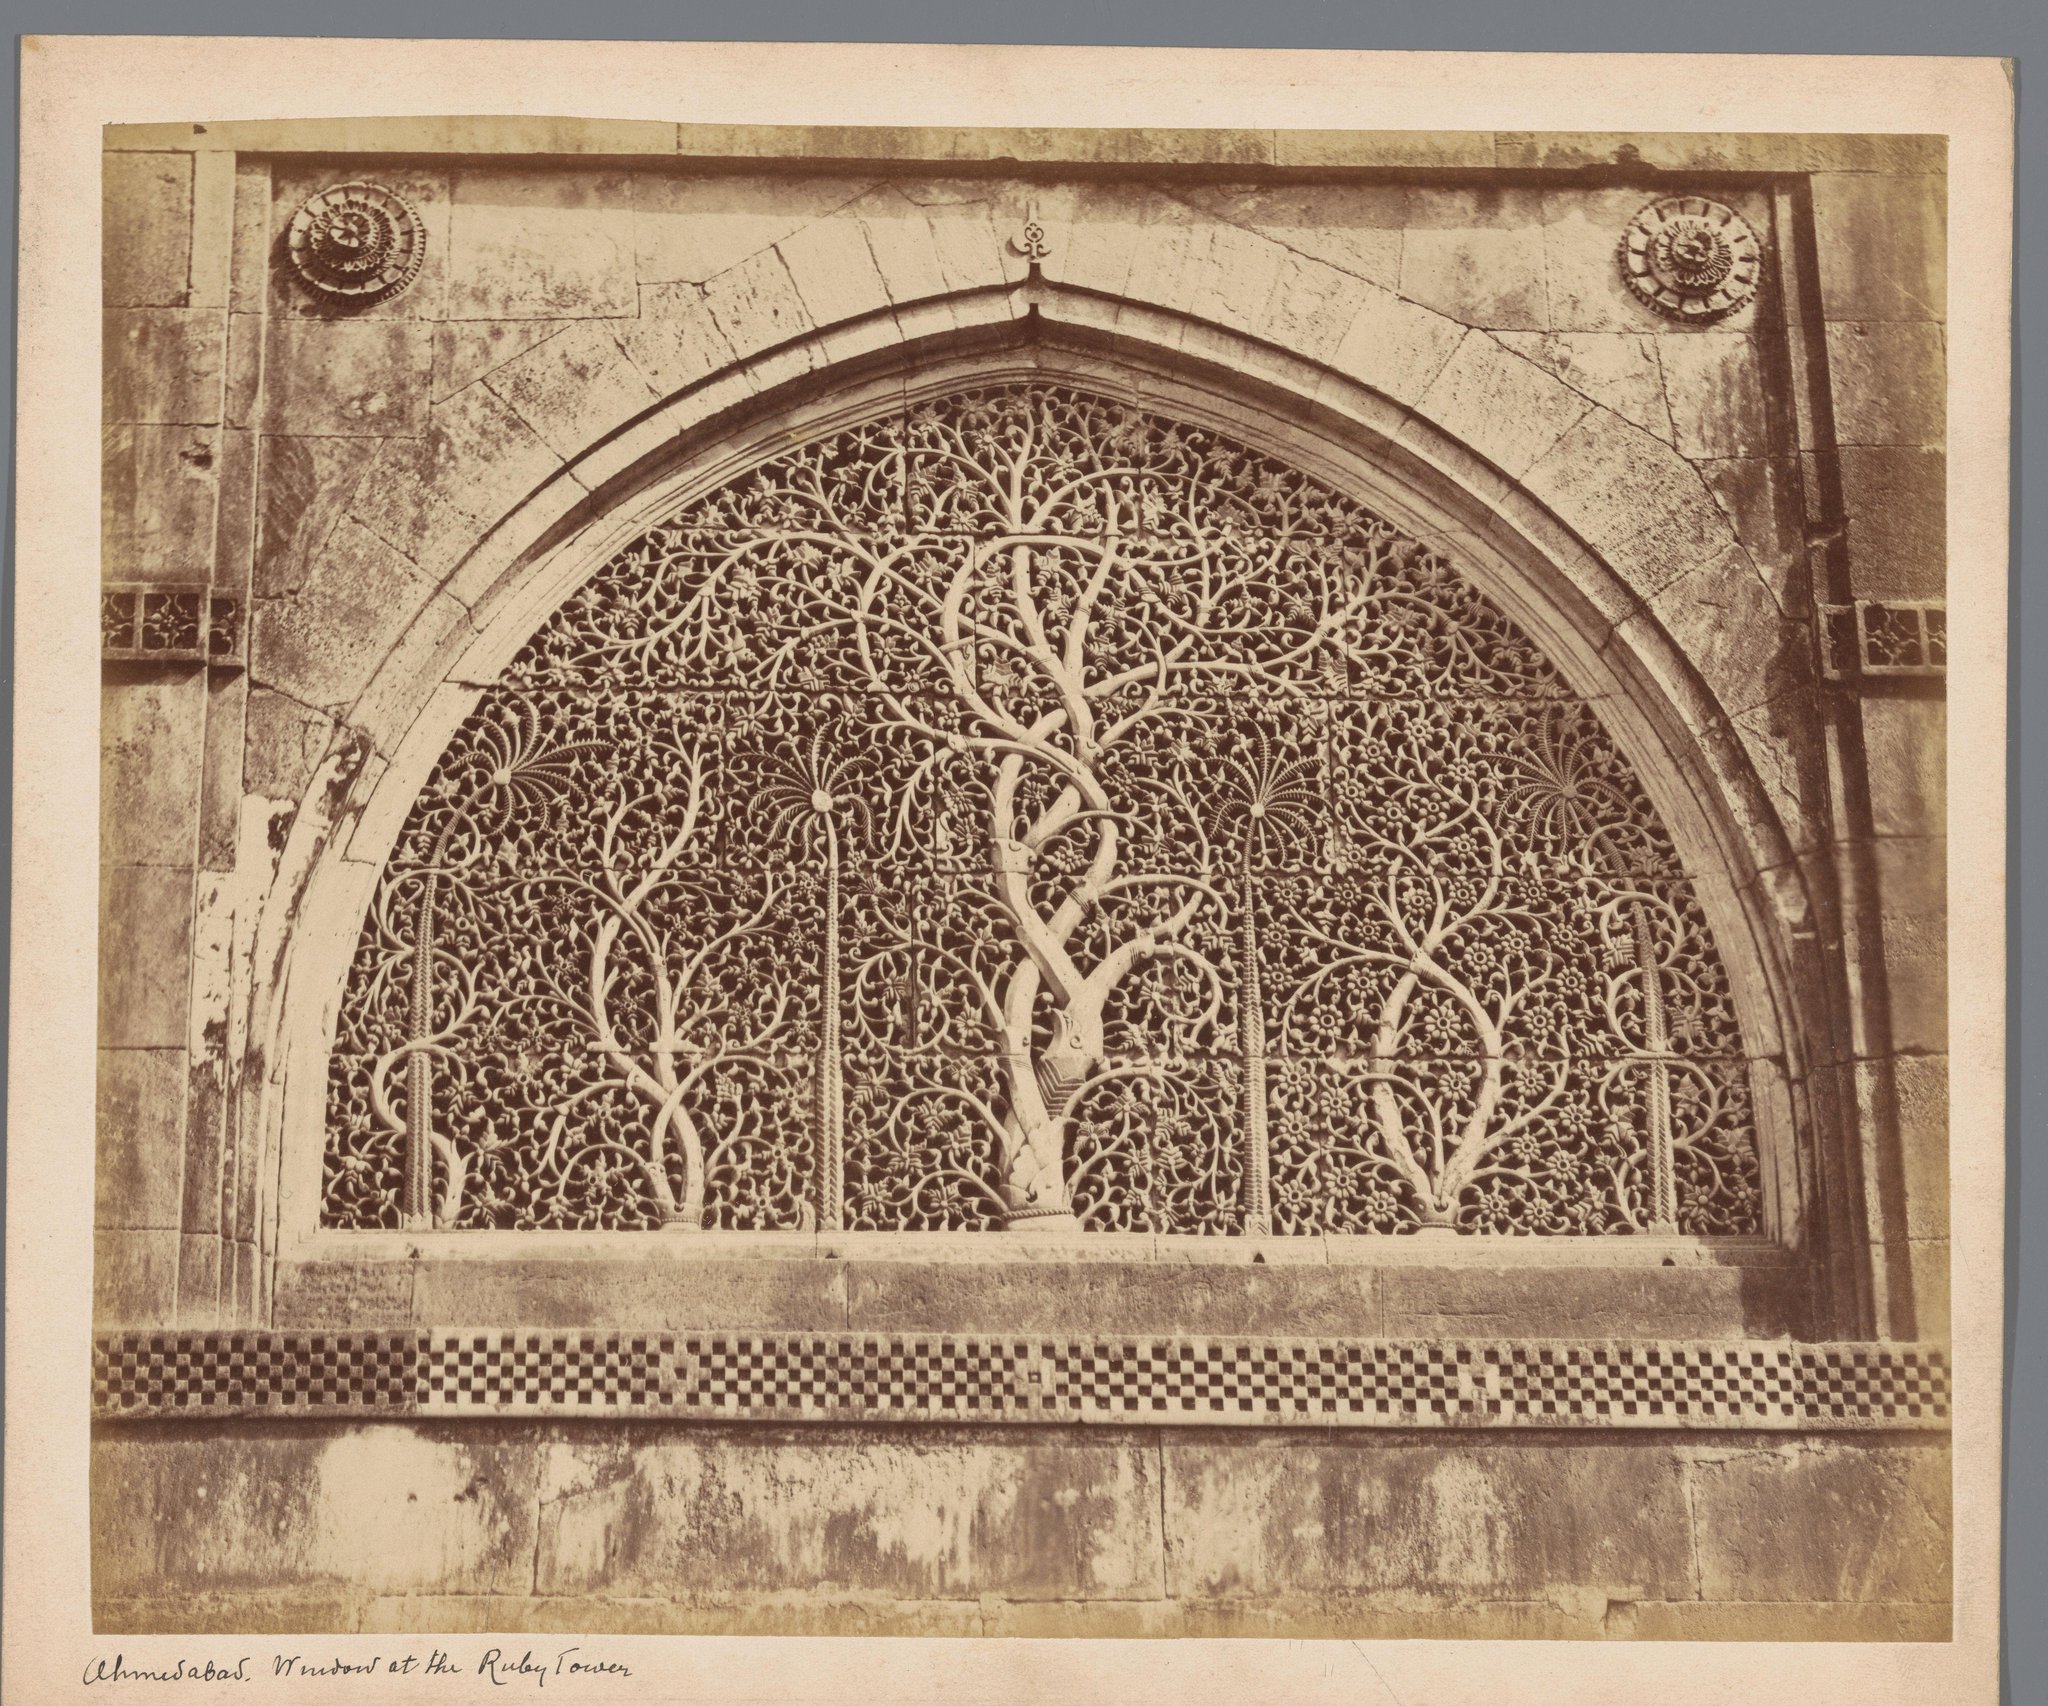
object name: photograph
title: Decorated window, Ahmedabad, Gujarat, India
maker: Anonymous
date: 1865-1890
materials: cardboard, paper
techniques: albumen print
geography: ahmedabad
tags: window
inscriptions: number: ‘18’